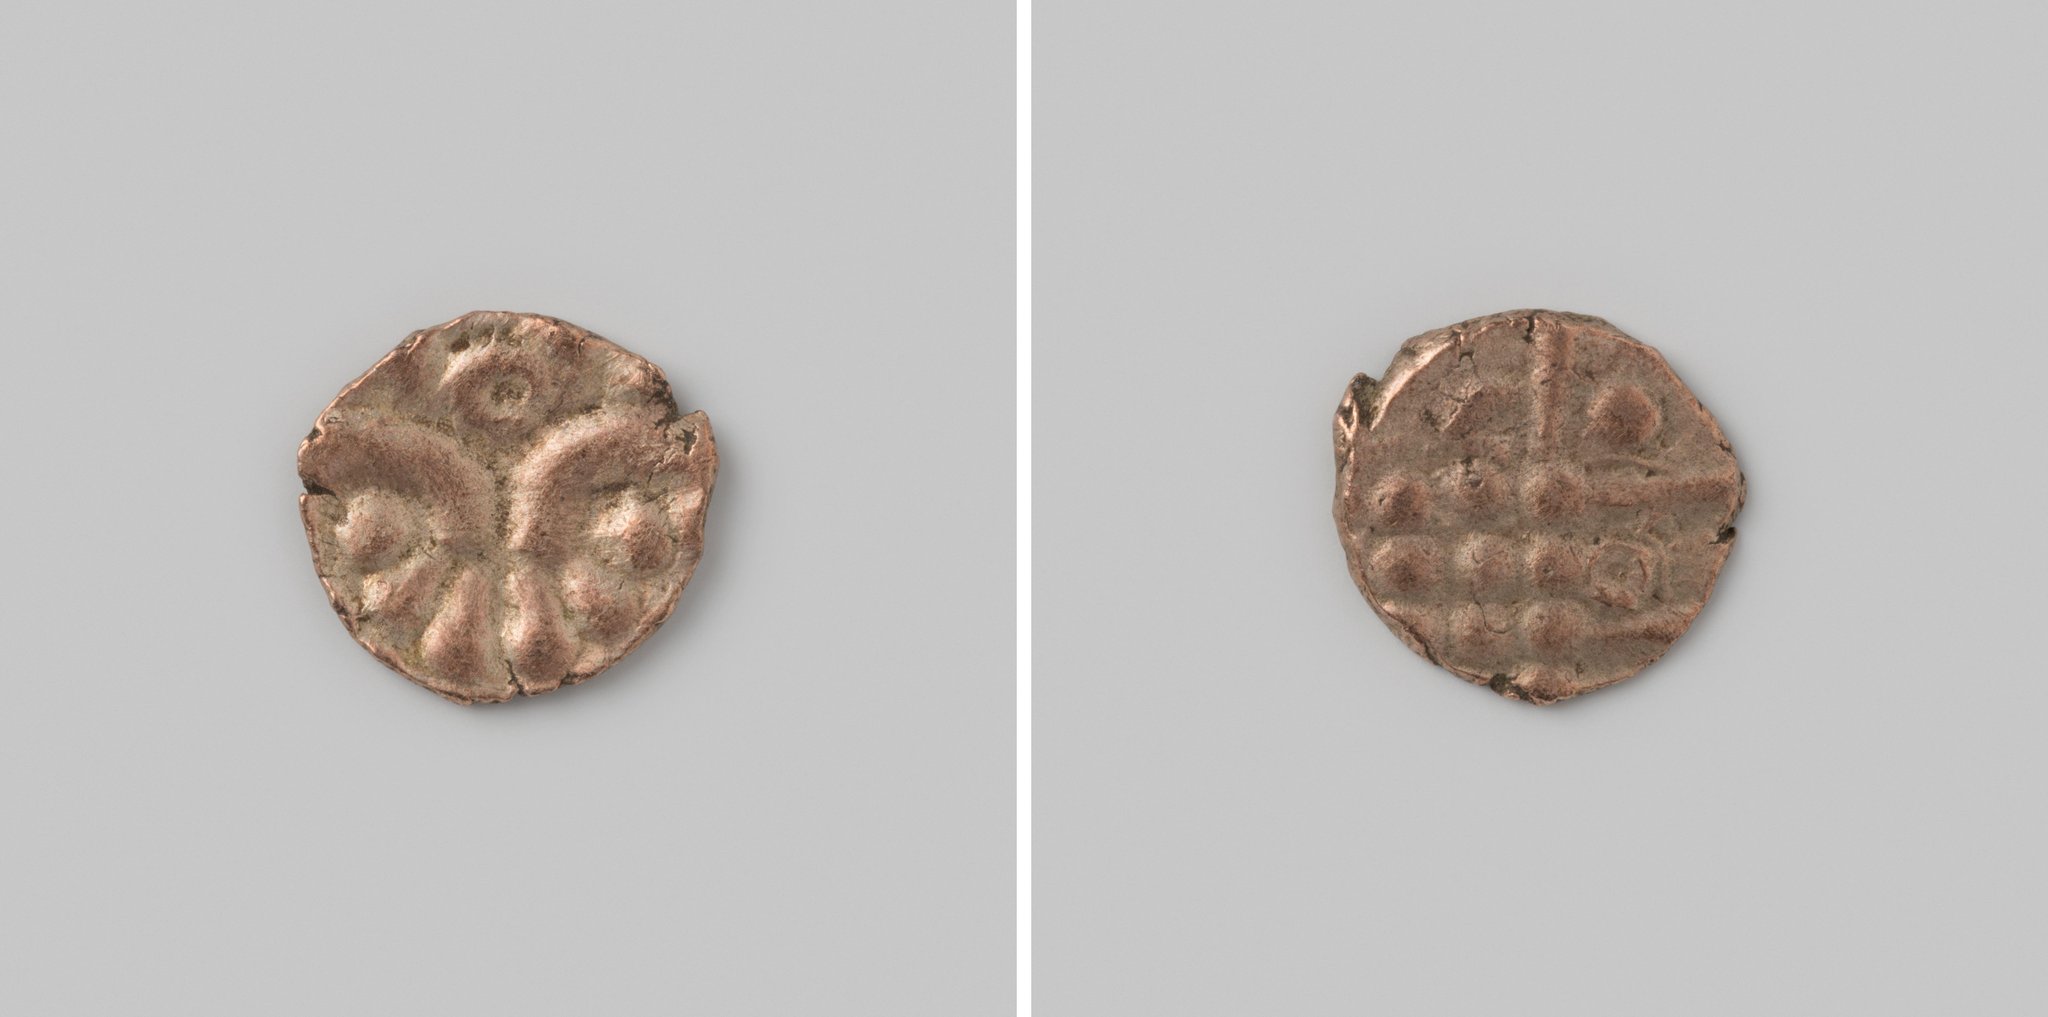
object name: gouden fanam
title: Gouden fanam uit Tinnevelli in India onder de Nayakas,1520-1736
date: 1520-1736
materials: gold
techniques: striking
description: Gouden munt. Voorzijde: aanziende godheid [?]. Keerzijde: versiering, waaronder drie rijen van elk vier stippen.